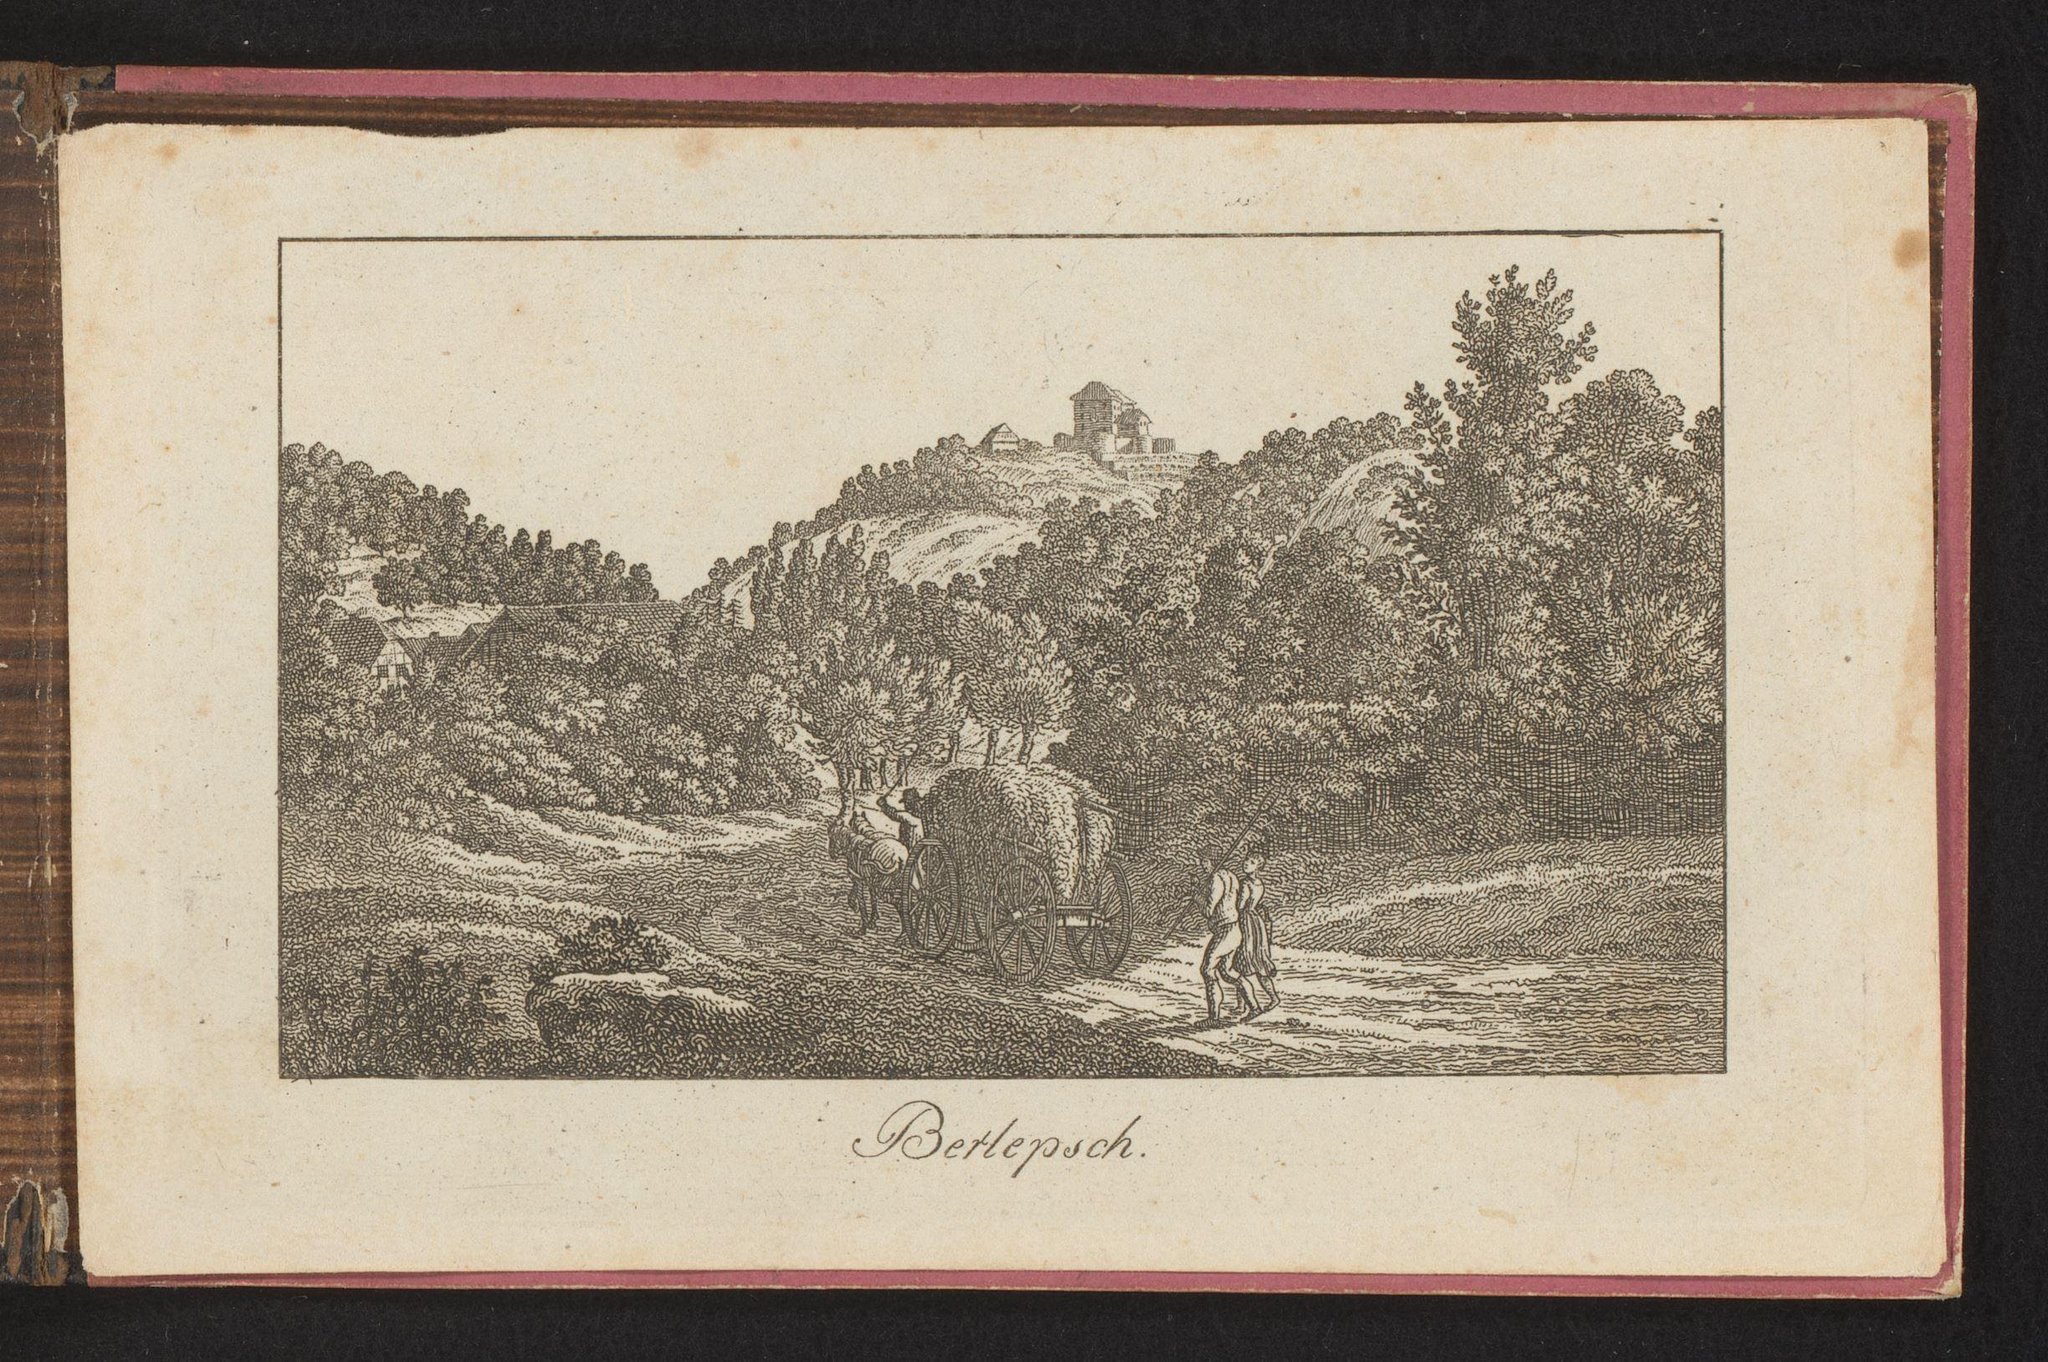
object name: print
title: Gezicht op het slot Berlepsch en een hooiwagen op een landweg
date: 1770-1826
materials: paper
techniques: etching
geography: gottingen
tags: 'album amicorum', 'stammbuch', low hill country (+ landscape with figures, staffage), hay-wagon